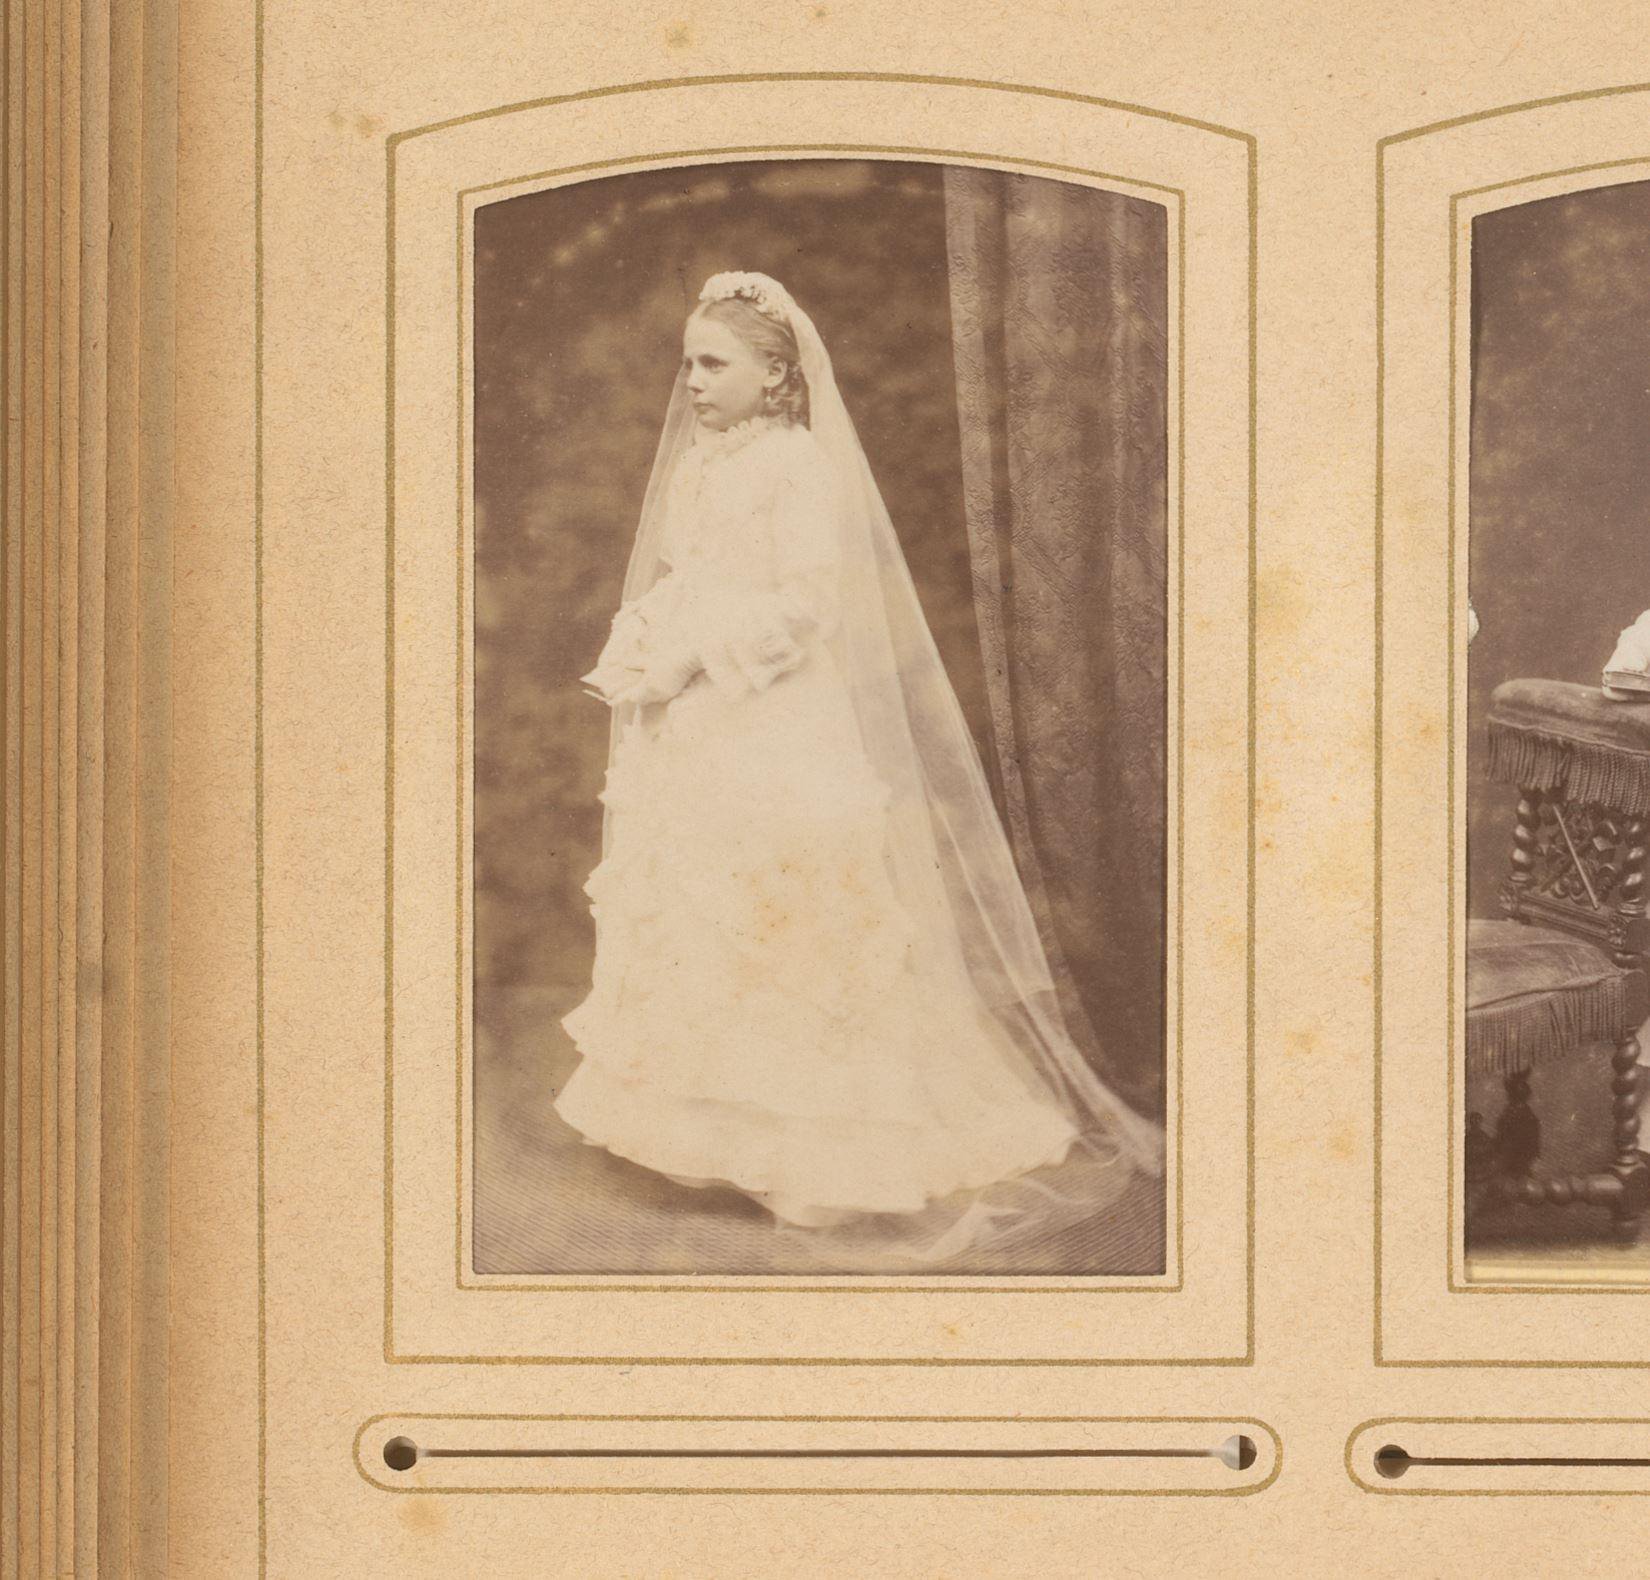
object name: photograph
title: Portret van een staand meisje in communiejurk met boek in de hand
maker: hermanus jodocus weesing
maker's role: fotograaf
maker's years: 1844-1910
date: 1868-1900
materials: cardboard, photographic support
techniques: albumen print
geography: amsterdam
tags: historical persons - bb - woman, communion dress, girl (child between toddler and youth), book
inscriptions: inscription: ‘Photographisch Atelier/ van/ H.J. WEESING/ AMSTERDAM/ 5, Binnen Brouwerstraat 5./ Voor nabestelling worden de platen bewaard.’